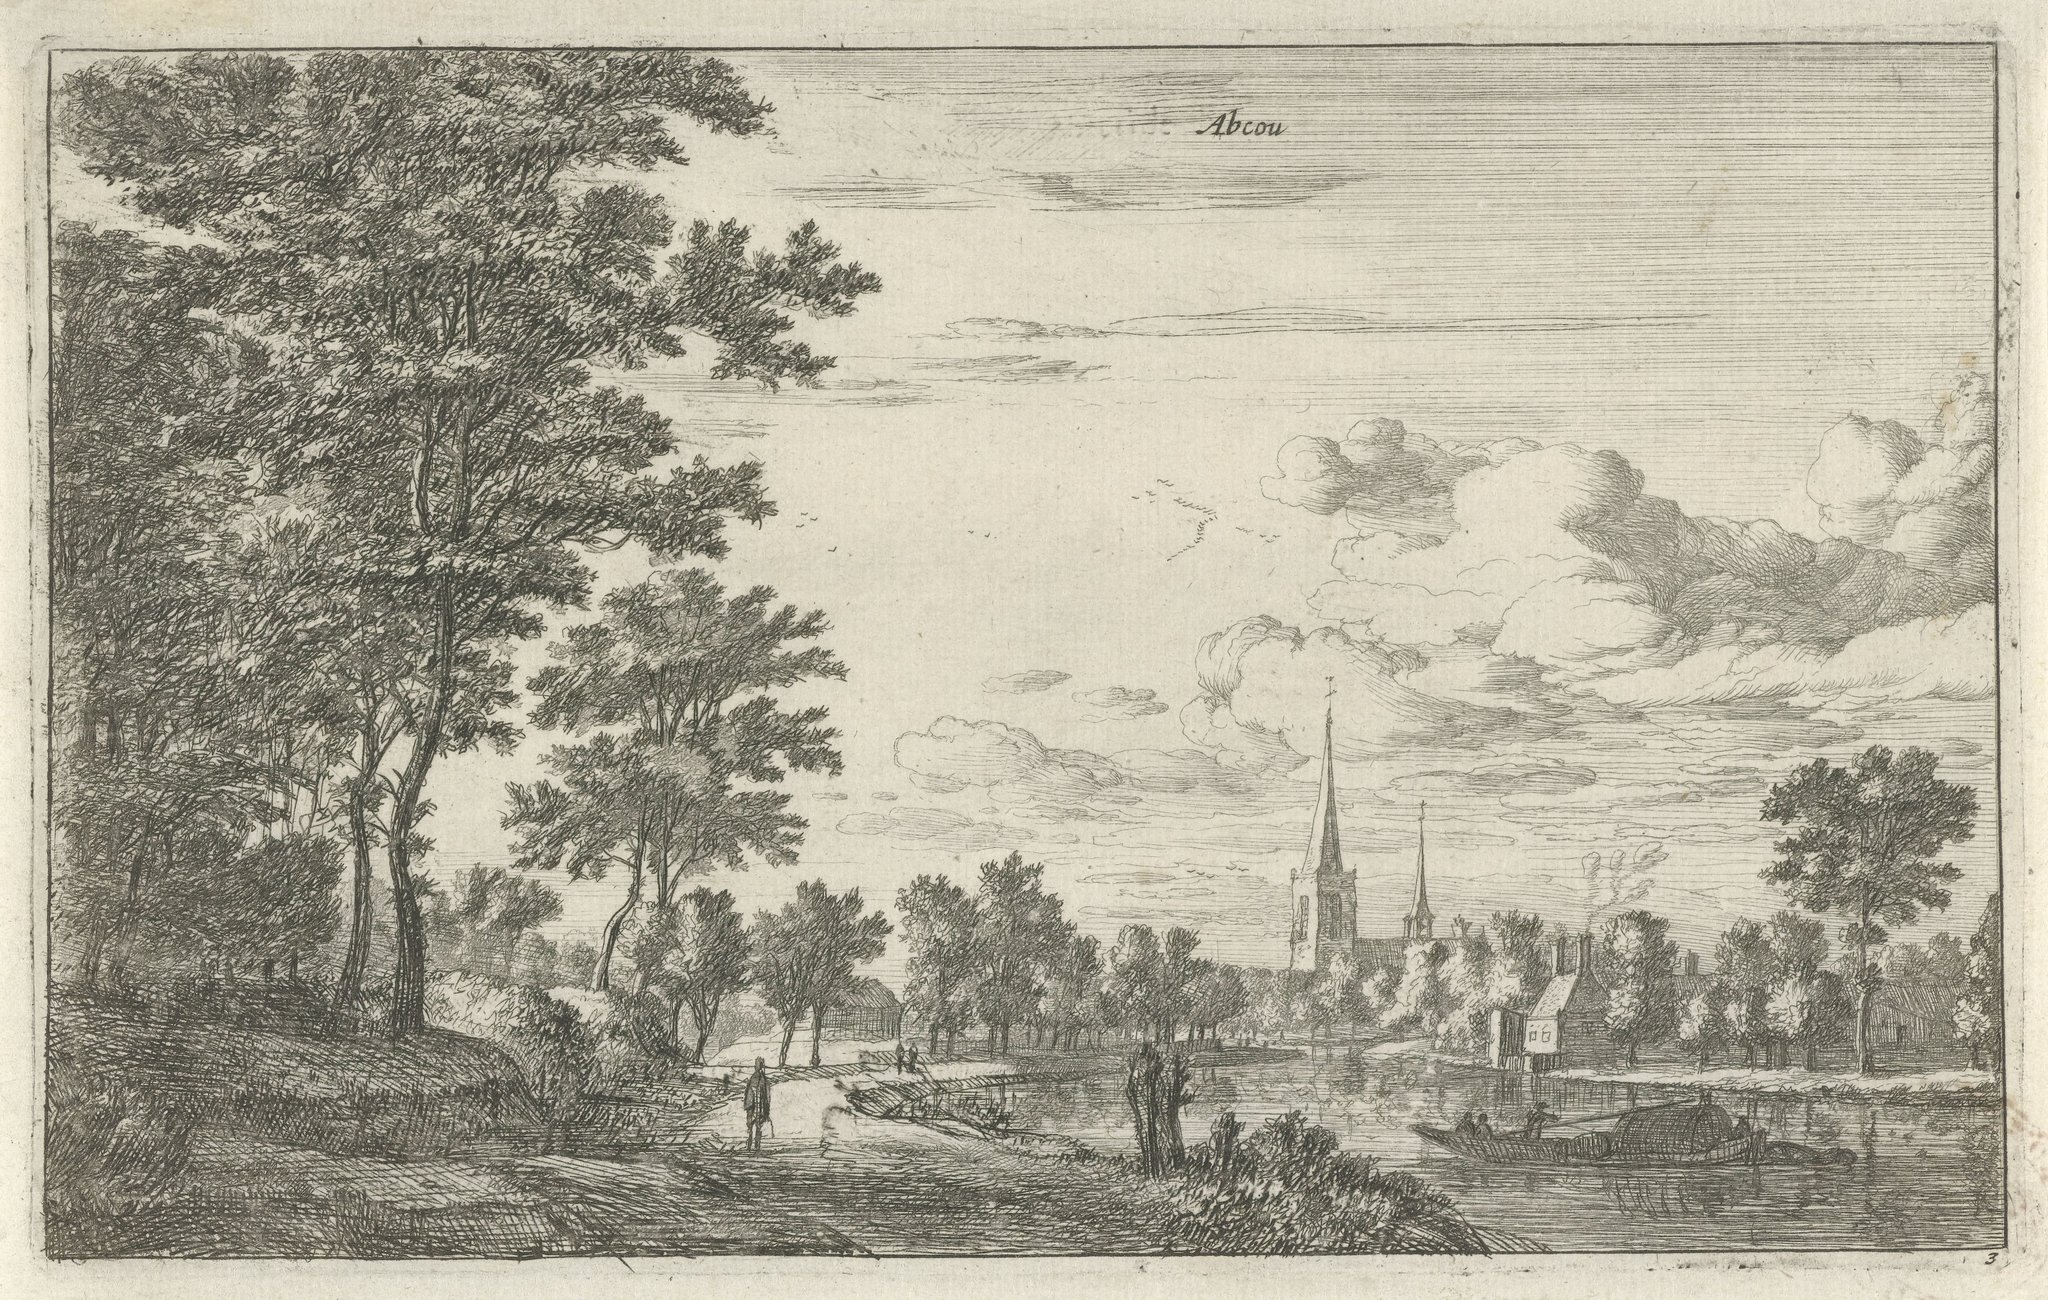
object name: print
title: Gezicht op Abcoude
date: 1643-1677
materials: paper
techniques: etching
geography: amsterdam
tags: prospect of village, silhouette of village, river, church (exterior), rowing-boat, canoe, etc., abcoude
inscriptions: collector's mark: Lugt 240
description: Gezicht vanaf een slingerweg op het dorp Abcoude met de kerk. Rechts een rivier met een boot. Rechtsonder genummerd: 3.